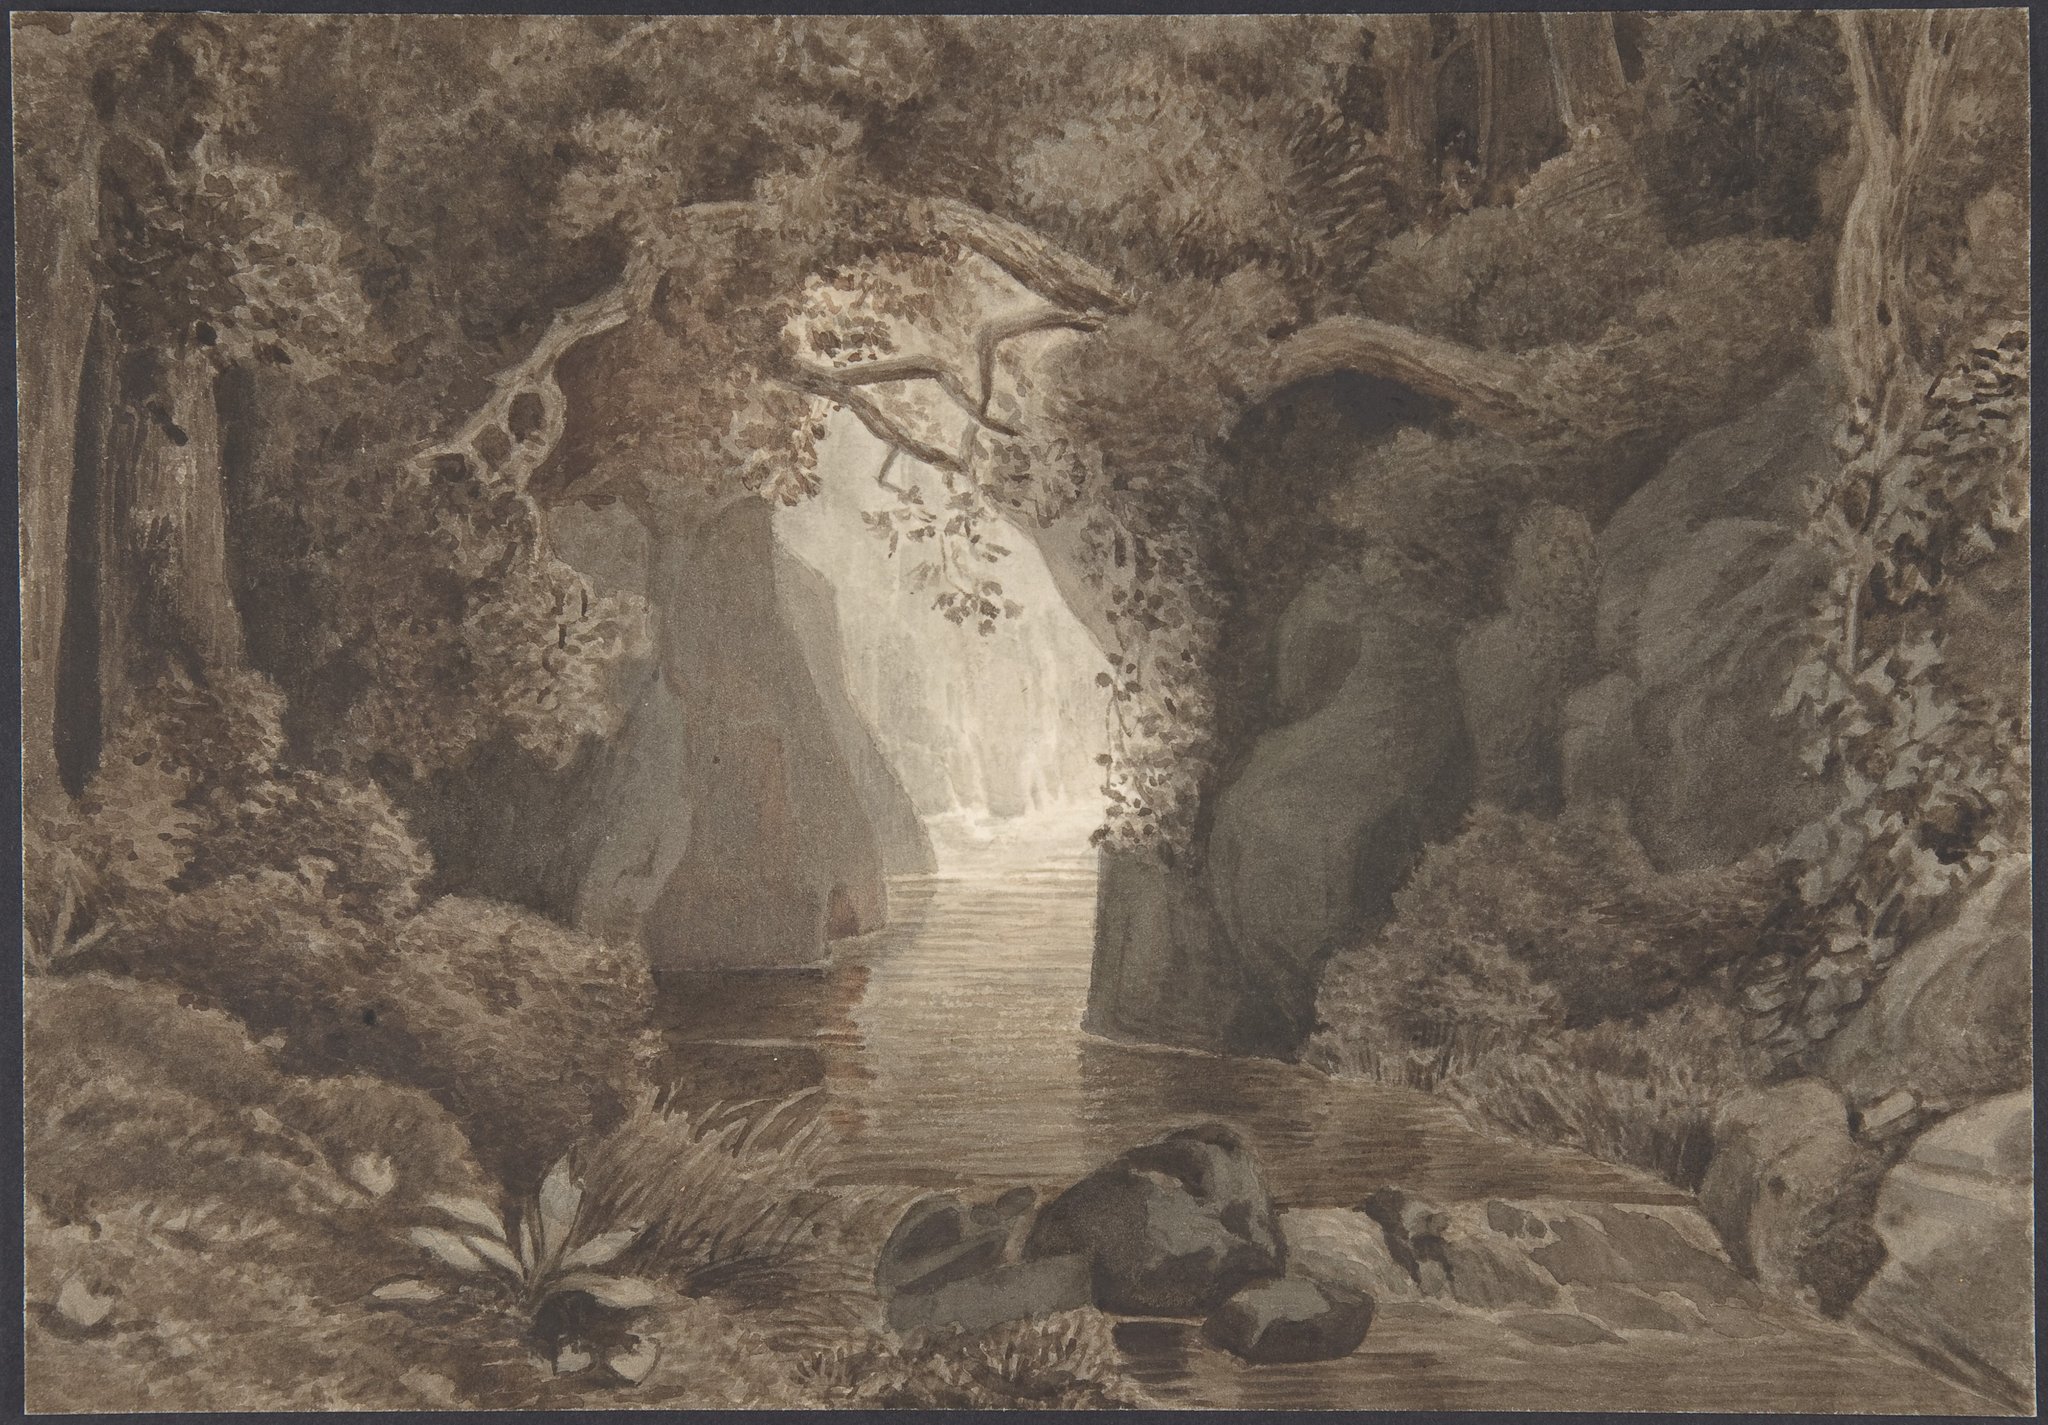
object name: drawing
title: Wooded Landscape with a Creek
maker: christoph nathe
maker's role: artist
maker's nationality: german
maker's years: 1753-1806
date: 1770-1806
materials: graphite, ink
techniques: brush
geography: germany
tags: landscapes